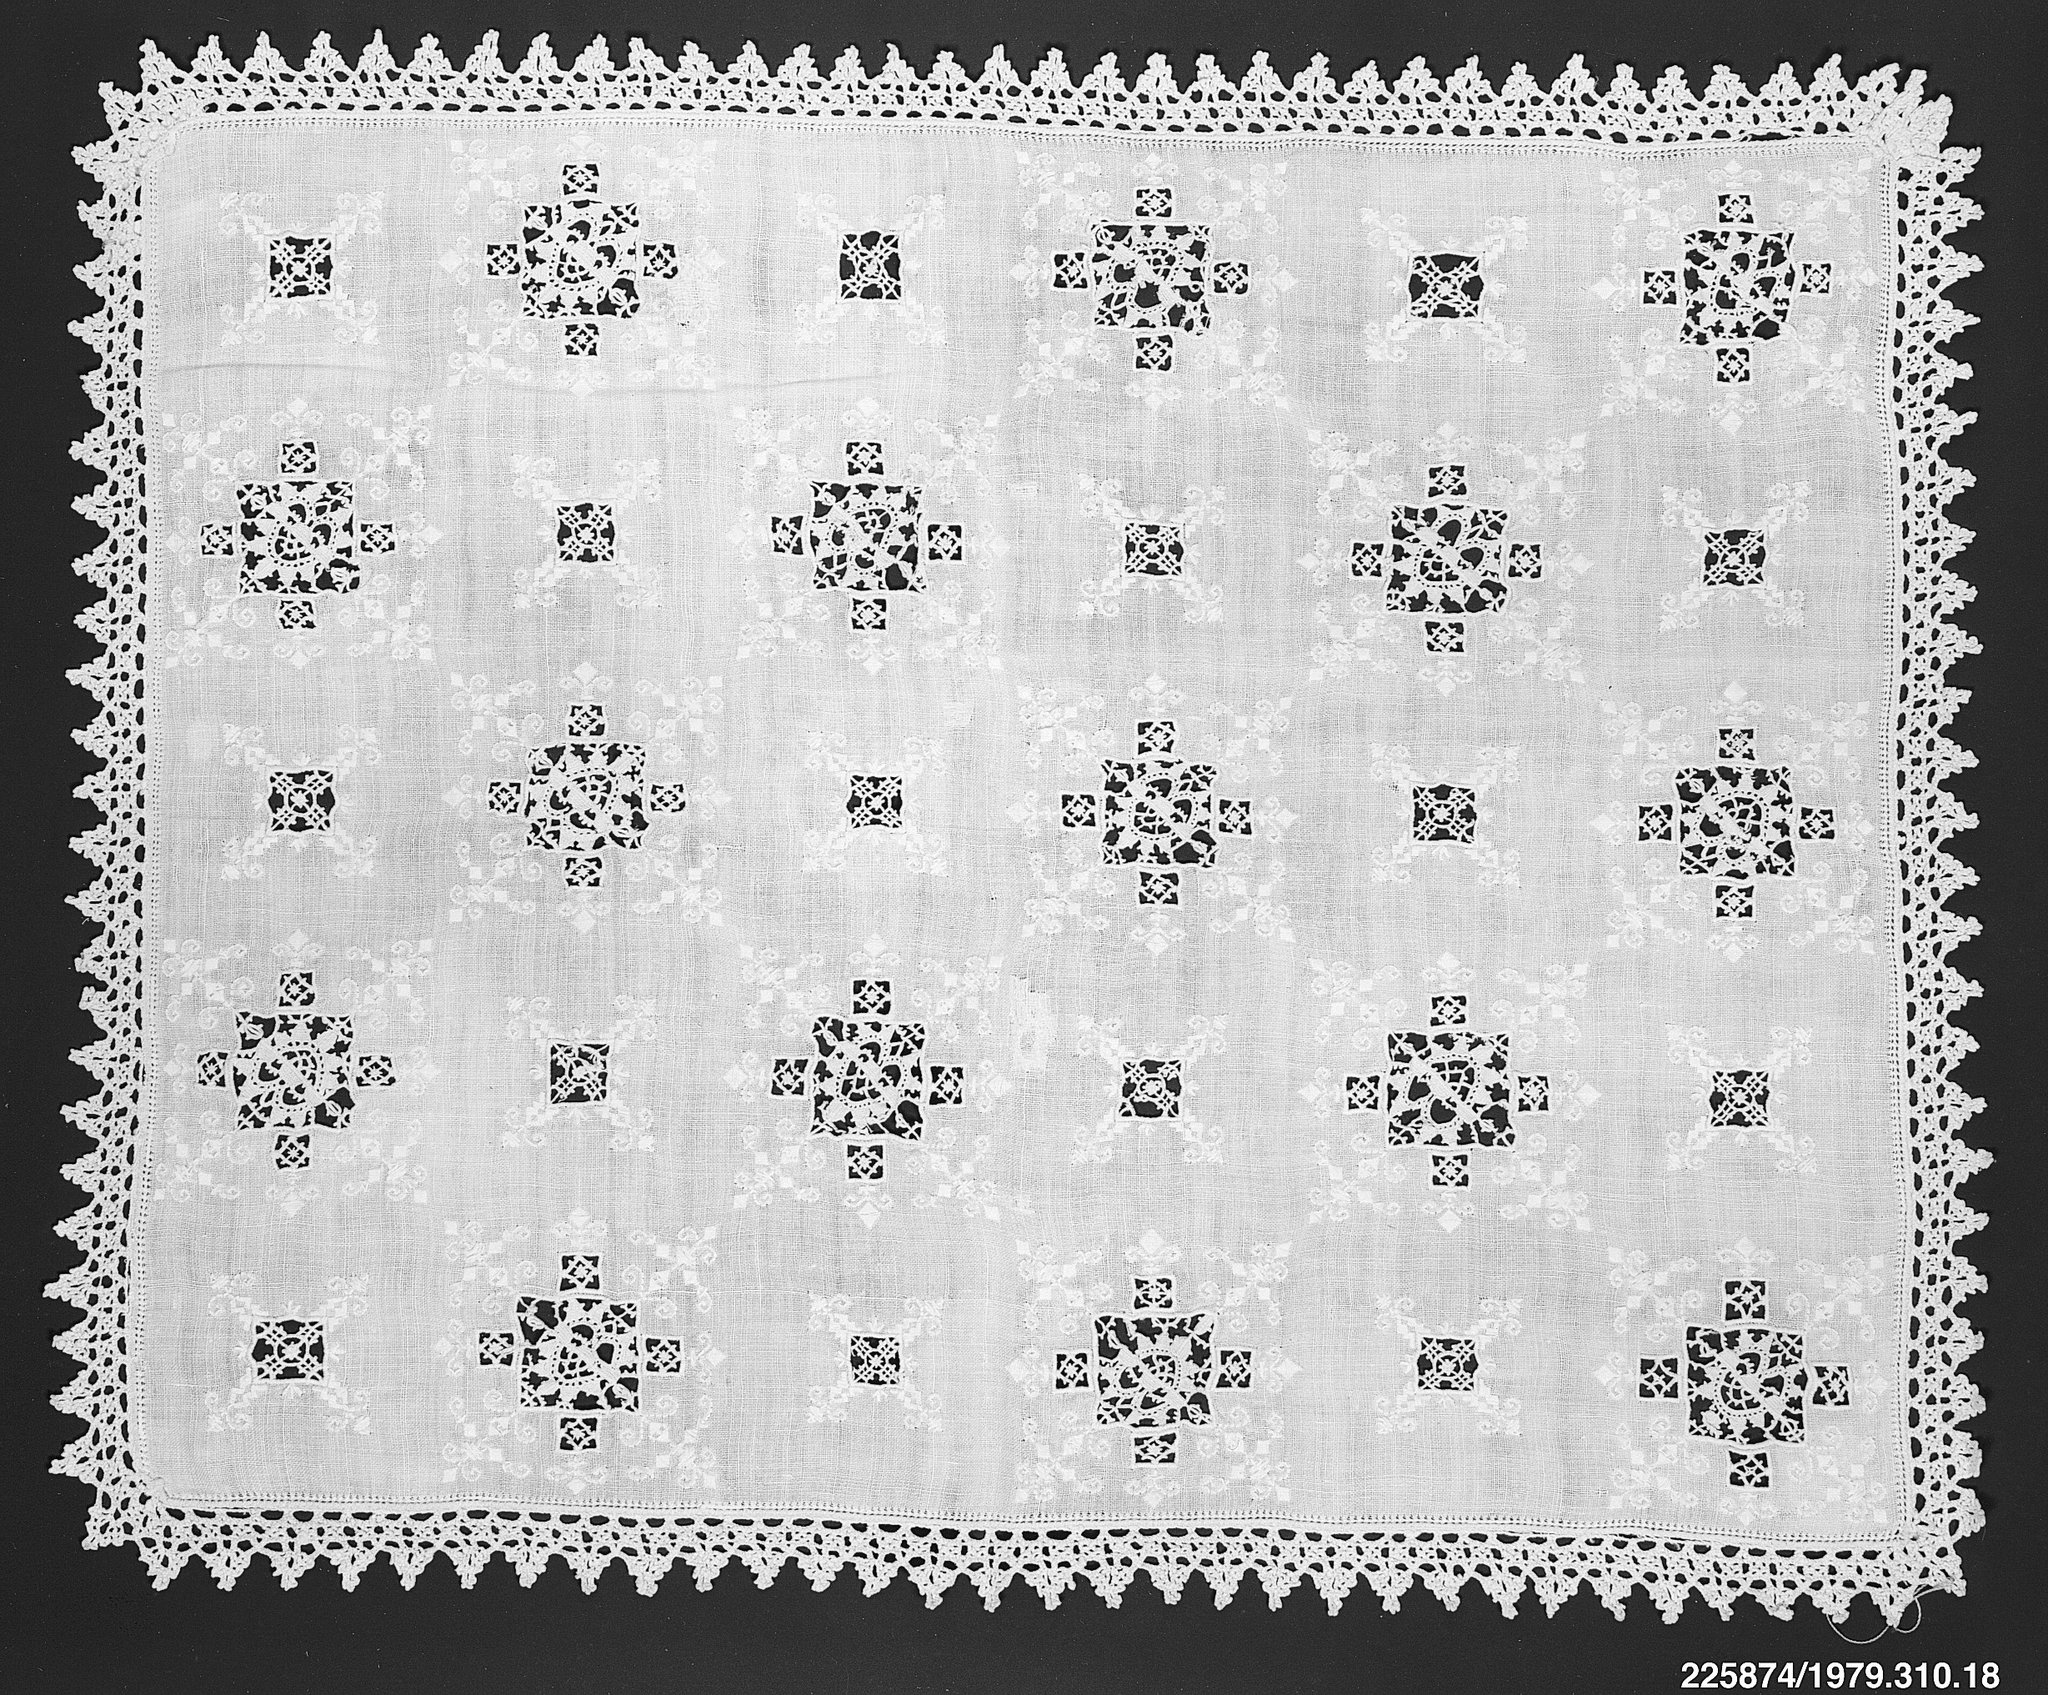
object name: mat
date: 1501-1600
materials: linen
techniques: lace